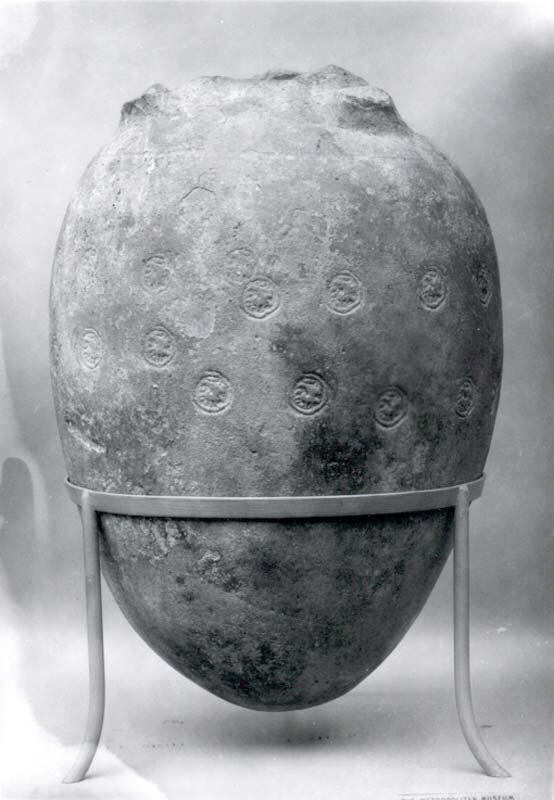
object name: jar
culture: sasanian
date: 201-400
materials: ceramic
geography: mesopotamia